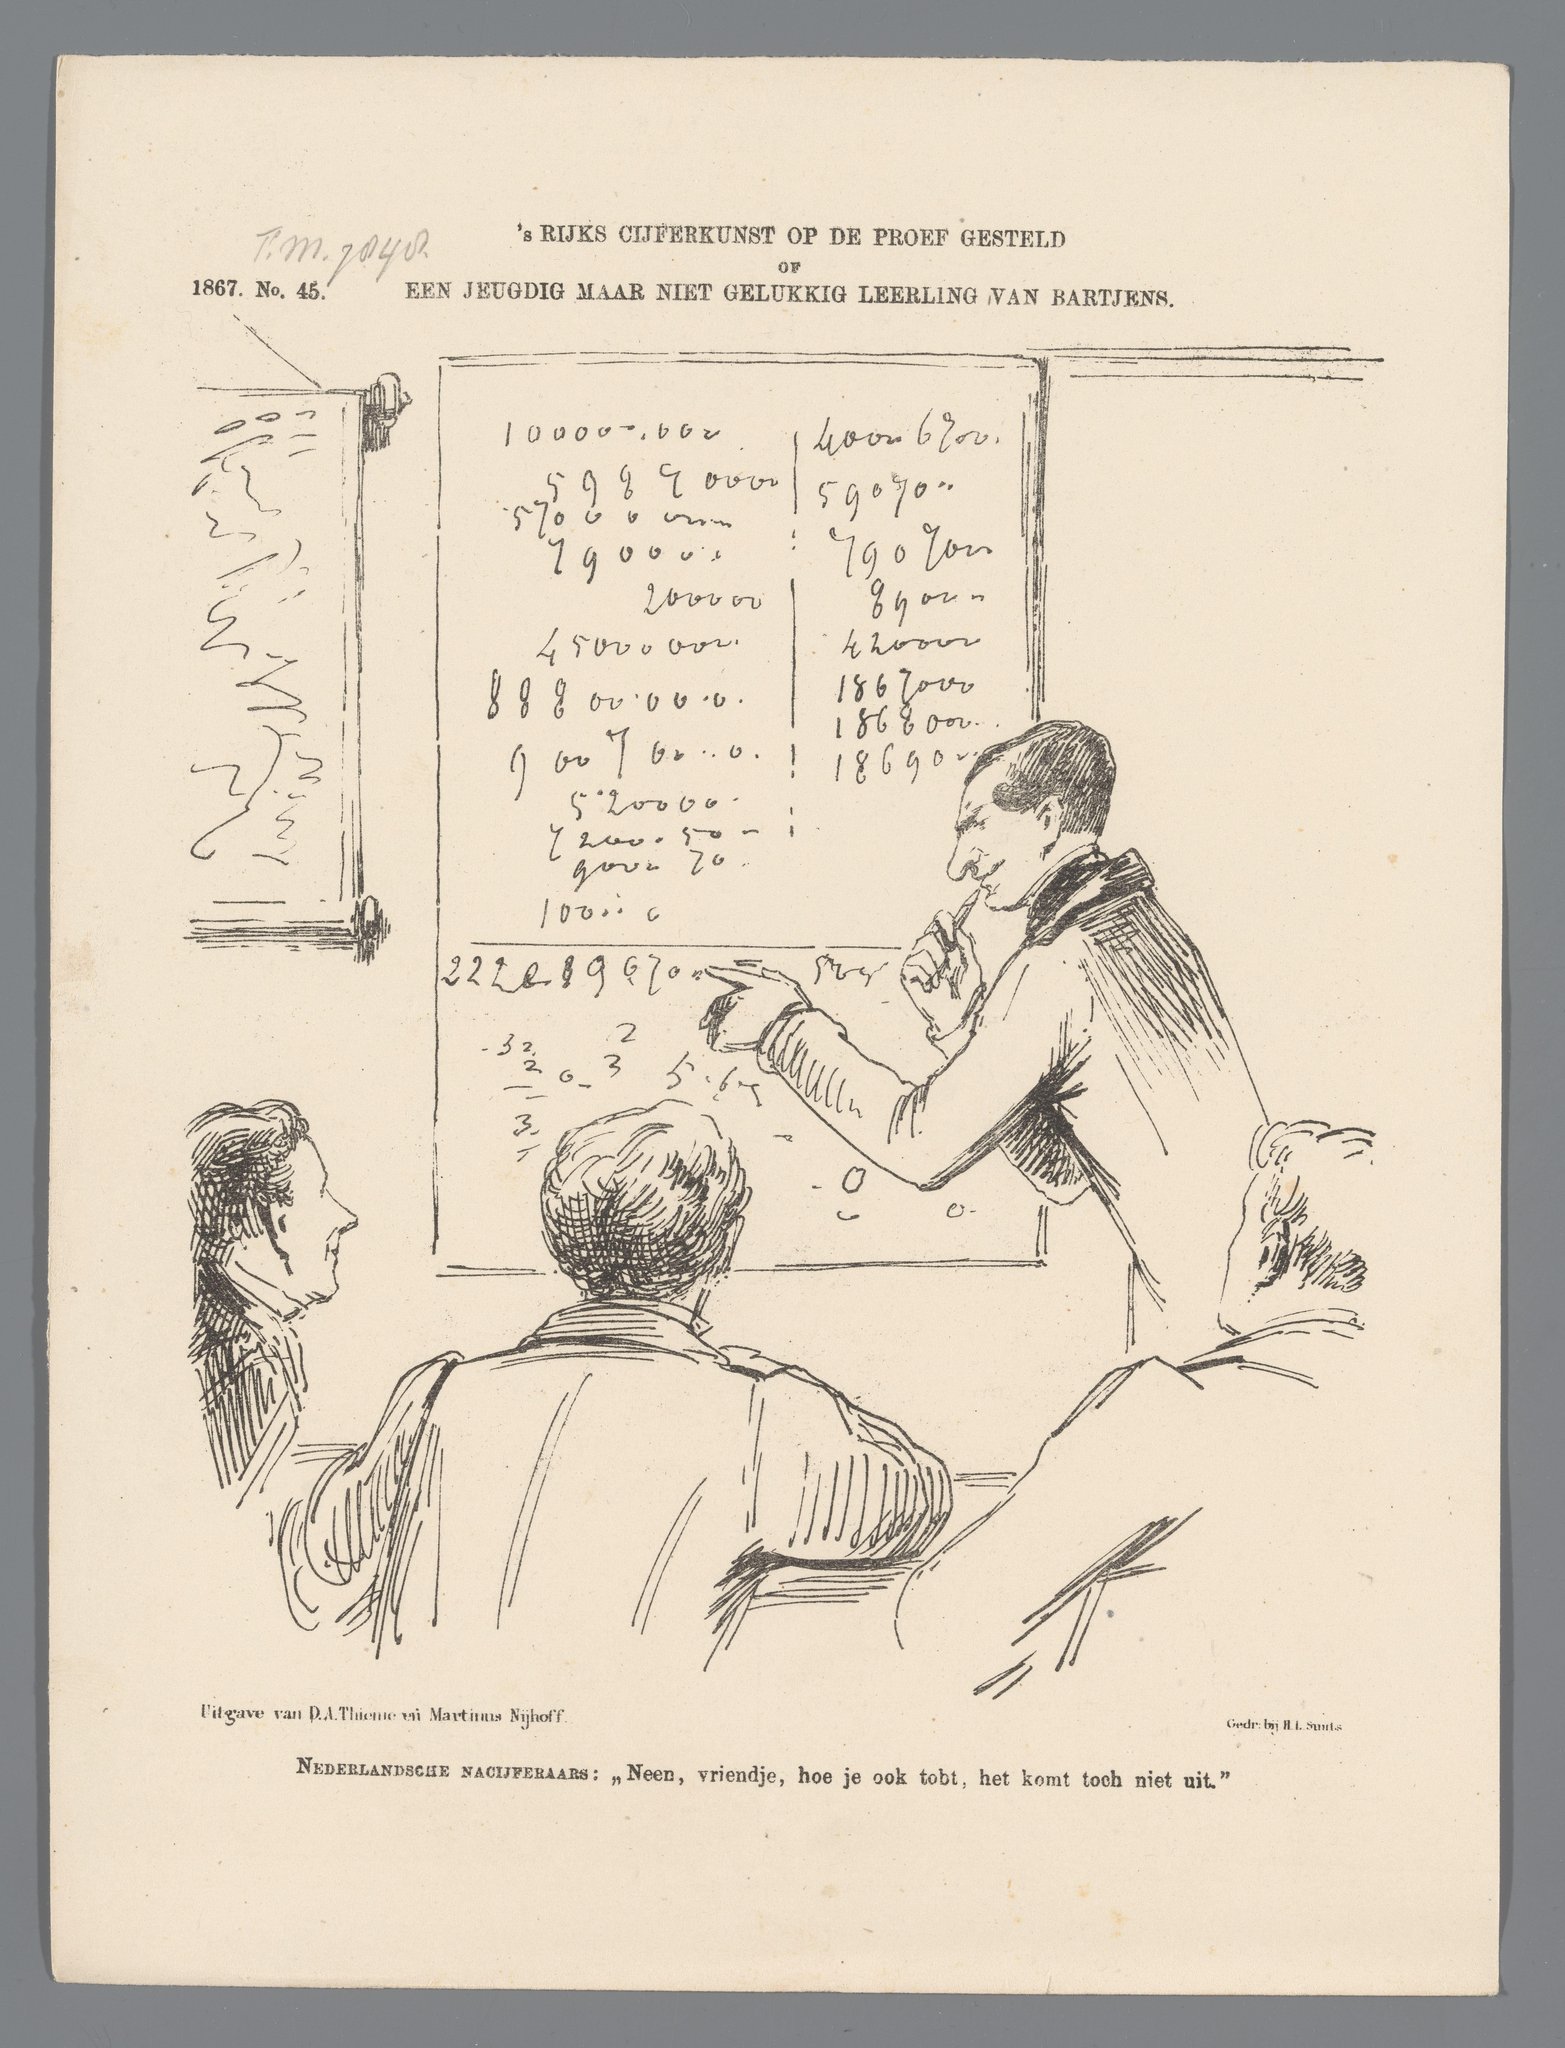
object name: cartoon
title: 's Rijks cijferkunst op de proef gesteld of Een jeugdig maar niet gelukkig leerling van Bartjens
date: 1867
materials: paper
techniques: lithograph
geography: arnhem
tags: the hague, rutger jan graaf schimmelpenninck van nyenhuis, arithmetic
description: Spotprent op de Minister van Financiën R.J. Schimmelpenninck die op een schoolbord een ingewikkelde rekensom probeert te maken. Plaat verschenen bij het weekblad De Nederlandsche Spectator, nr. 45, 9 november 1867.